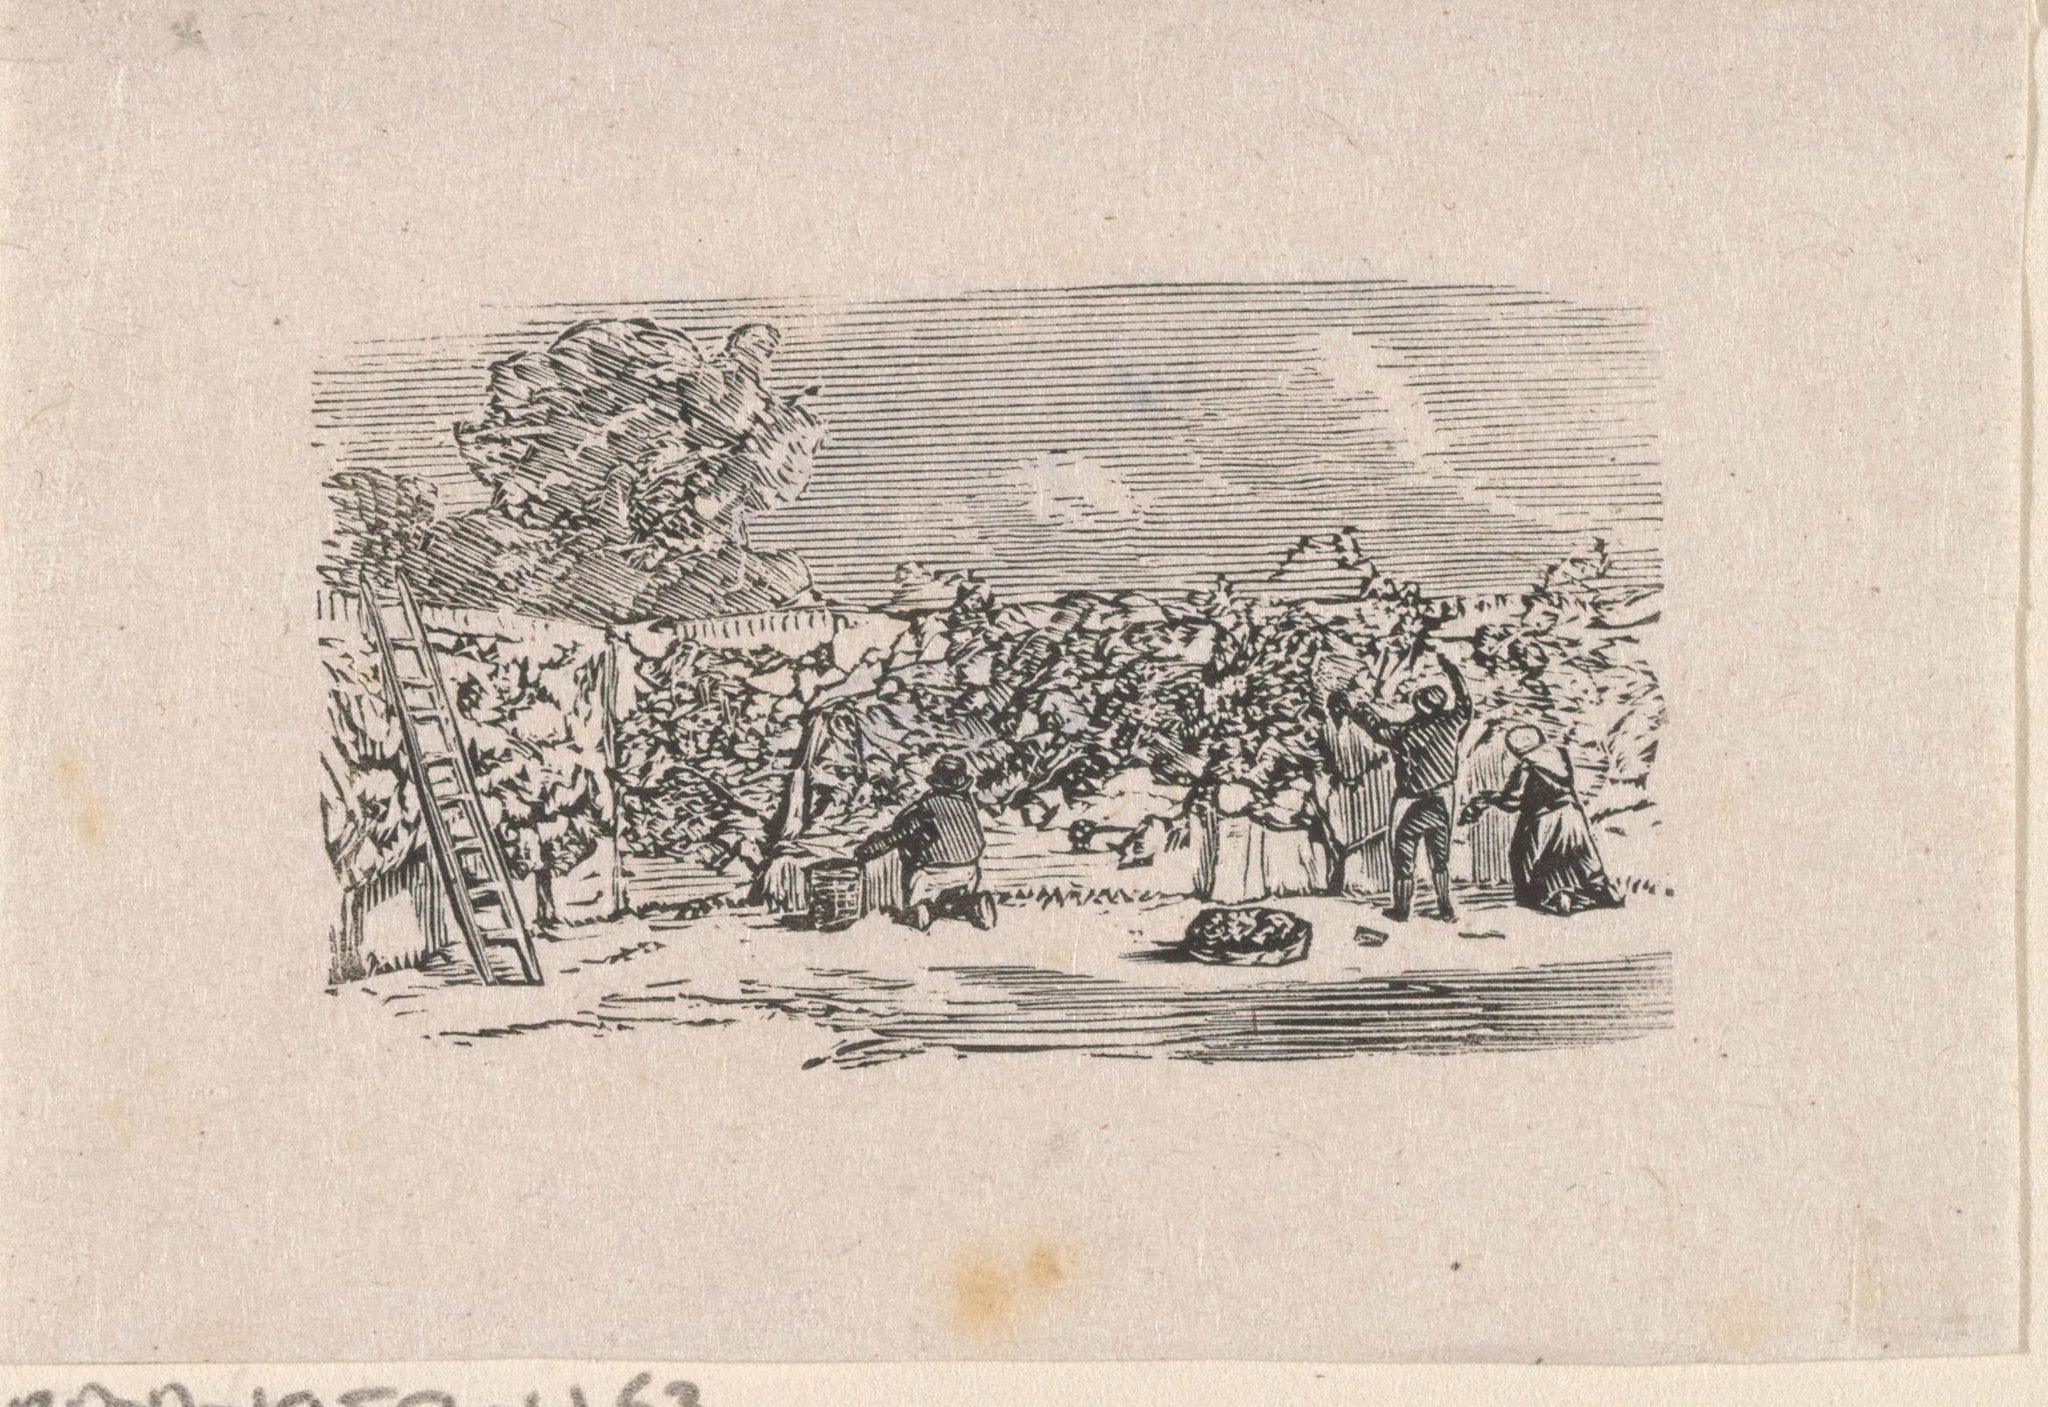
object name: print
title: Maanden van het jaar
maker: isaac weissenbruch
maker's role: print maker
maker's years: 1826-1912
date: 1836-1912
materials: paper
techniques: engraving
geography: netherlands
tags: the twelve months represented by scenes showing human activities, usually in a landscape; so-called 'labours of the months', adult woman (+ kneeling), adult man (+ standing), orchard, adult man (+ kneeling)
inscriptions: collector's mark: Lugt 2228